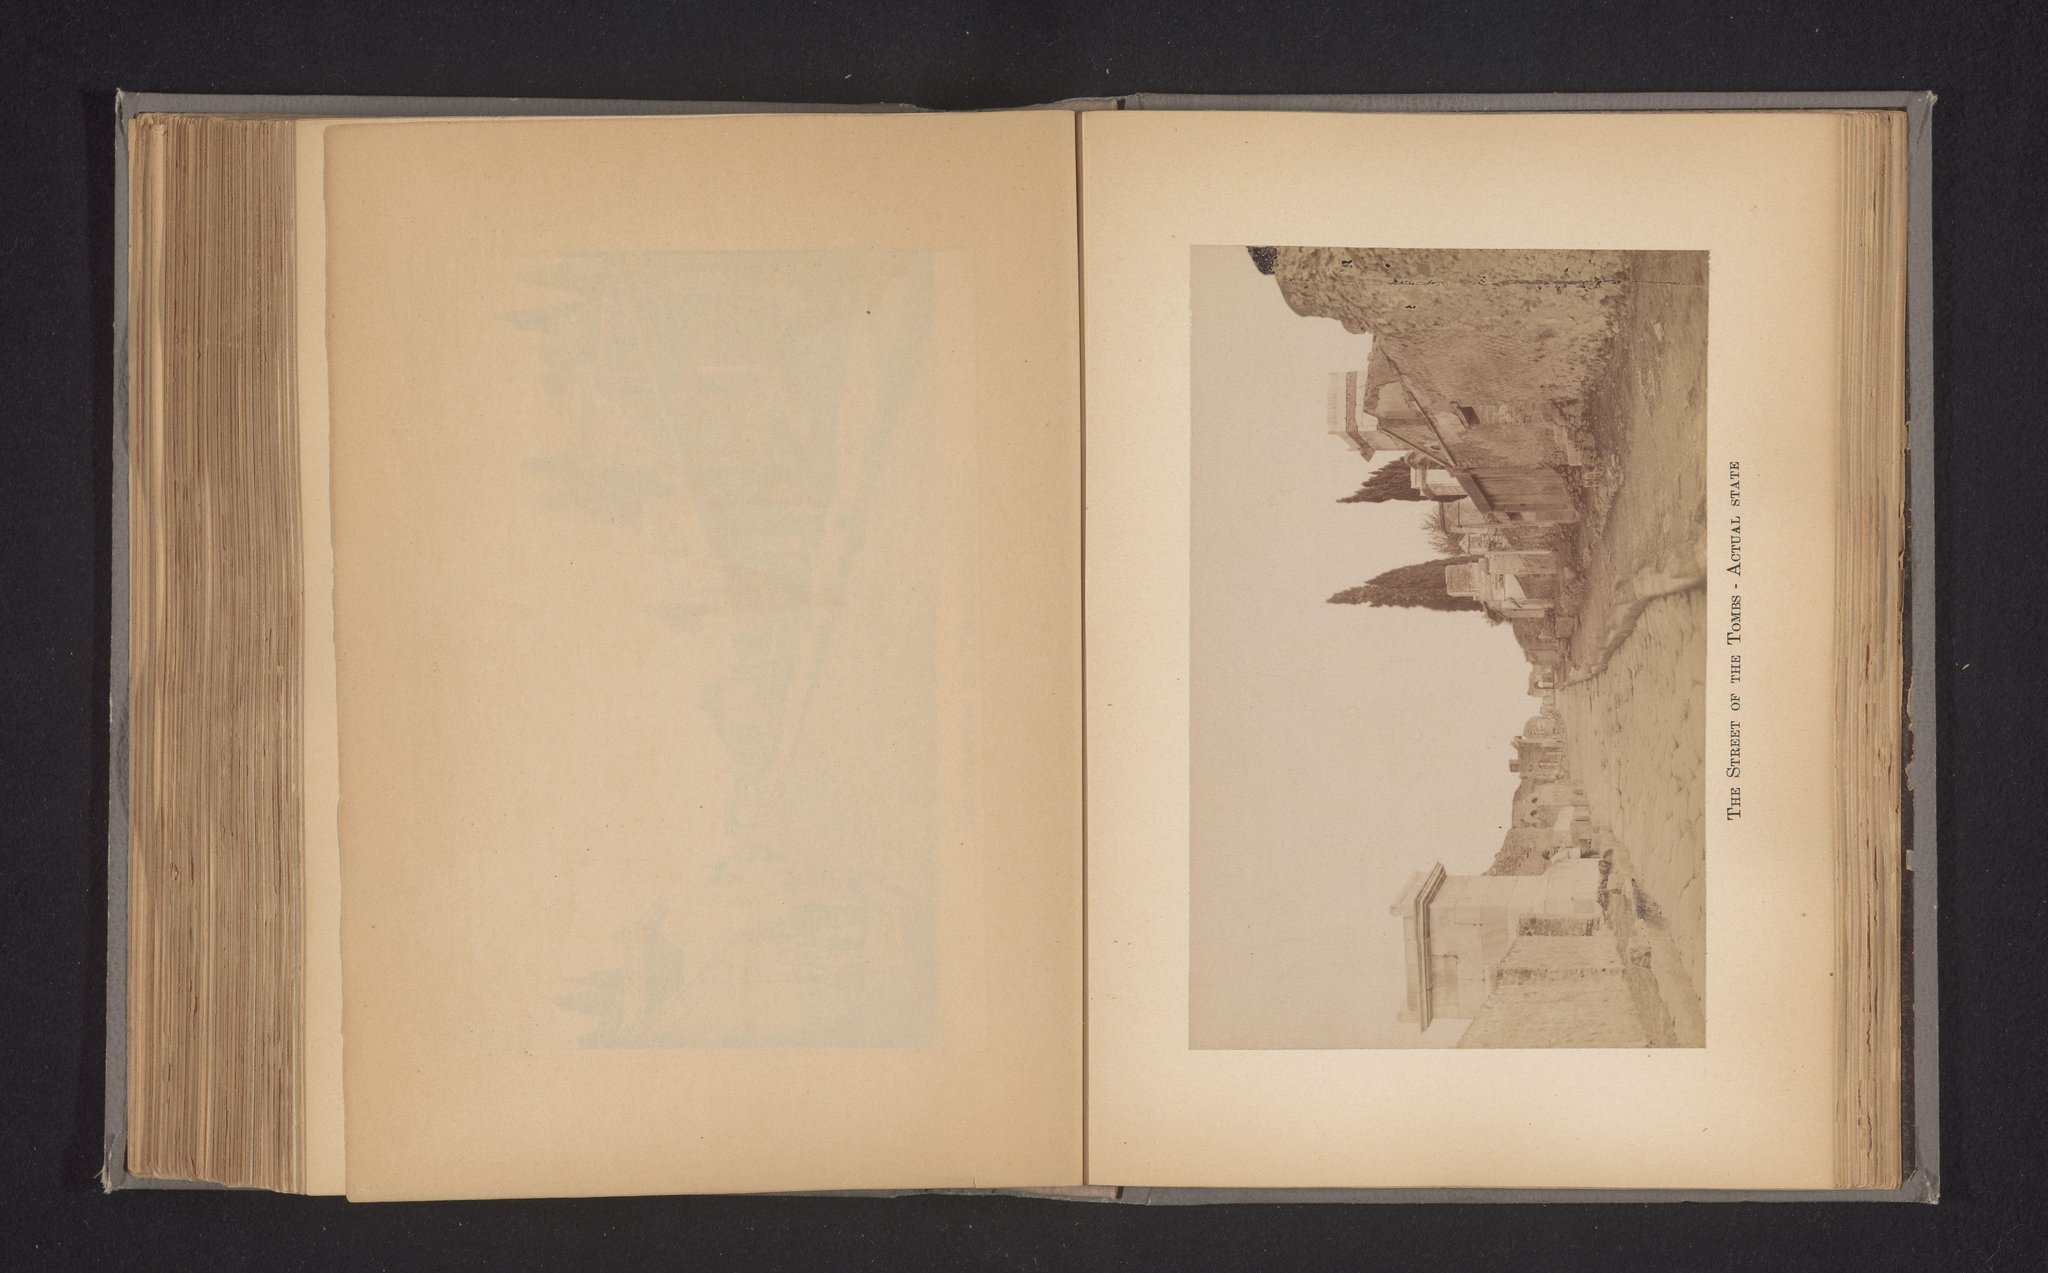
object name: page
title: The street of the tombs - Actual State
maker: Anonymous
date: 1890-1895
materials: photographic support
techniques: albumen print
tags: grave, tomb, street